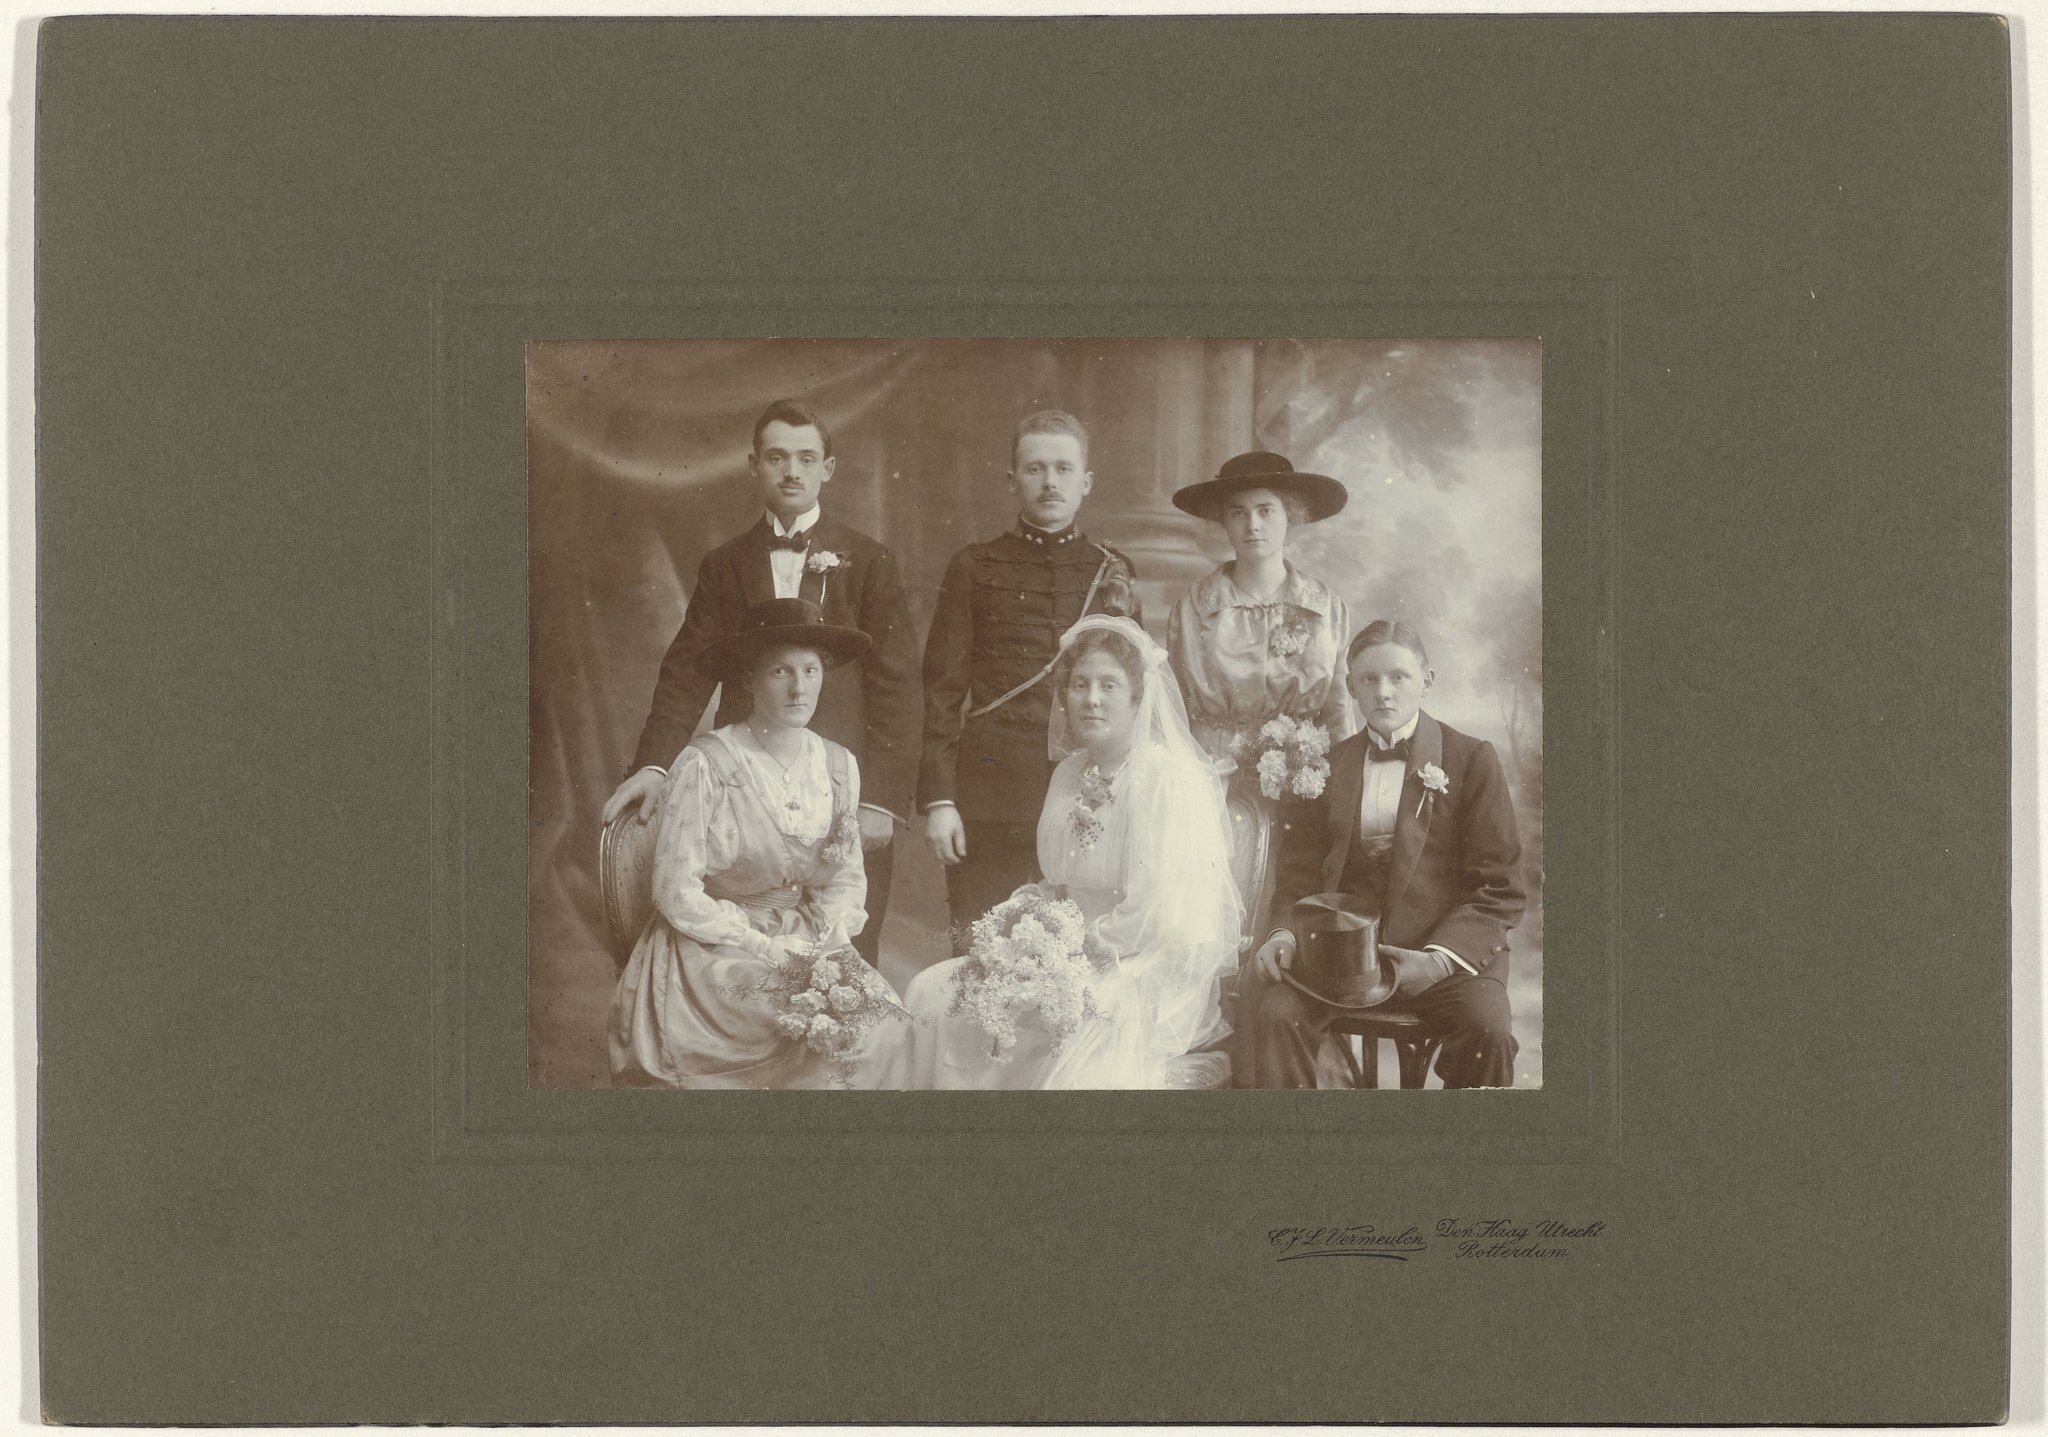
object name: photograph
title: Bruidsfoto ter gelegenheid van de bruiloft van Klaas Kleiterp en Tine Vermeulen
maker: cornelis johannes lodewicus vermeulen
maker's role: fotograaf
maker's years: 1861-1936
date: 1918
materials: photographic support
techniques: carbon print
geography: the hague